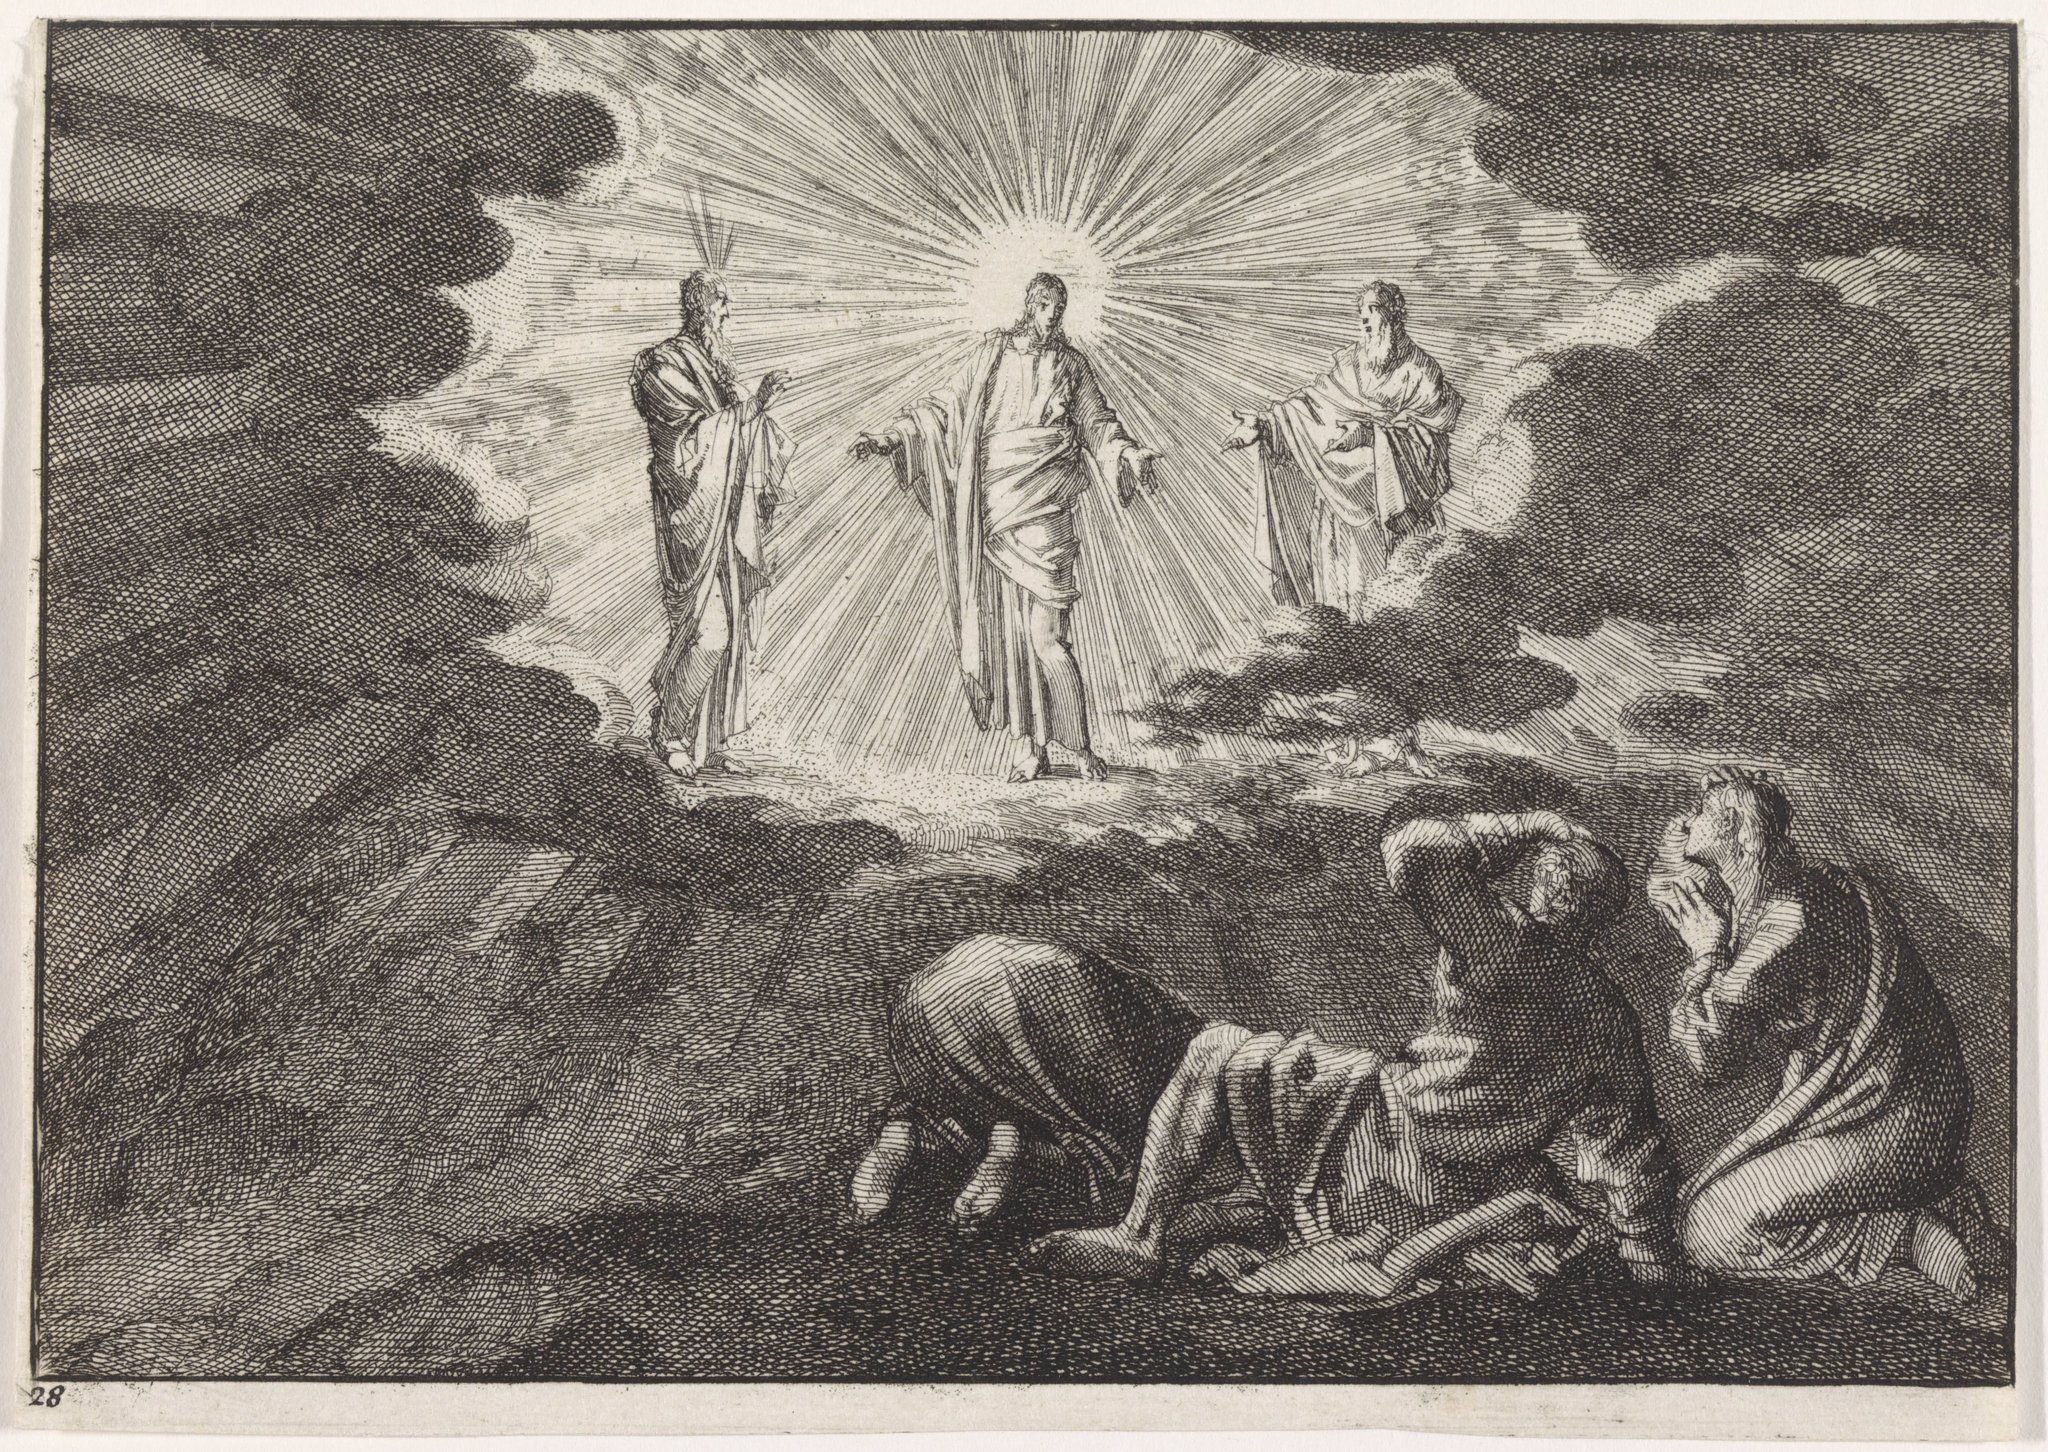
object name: print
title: Transfiguratie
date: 1703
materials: paper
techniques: etching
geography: haarlem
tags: the transfiguration: moses and elijah appear on either side of christ on mount tabor (matthew 17:1-13; mark 9:2-13; luke 9:28-36)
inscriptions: collector's mark: Lugt 2228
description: Proefdruk van een boekillustratie voor David Martin. Historie des Ouden en Nieuwen Testaments. Amsterdam, Pieter Mortier, 1703. Deel II. De boekillustraties voor de Mortierbijbel hebben verschillende staten en kopieën, waarbij de chronologische volgorde moeilijk te achterhalen valt. Als boekillustraties werden ze bovendien herhaaldelijk opnieuw gebruikt voor andere boekwerken.